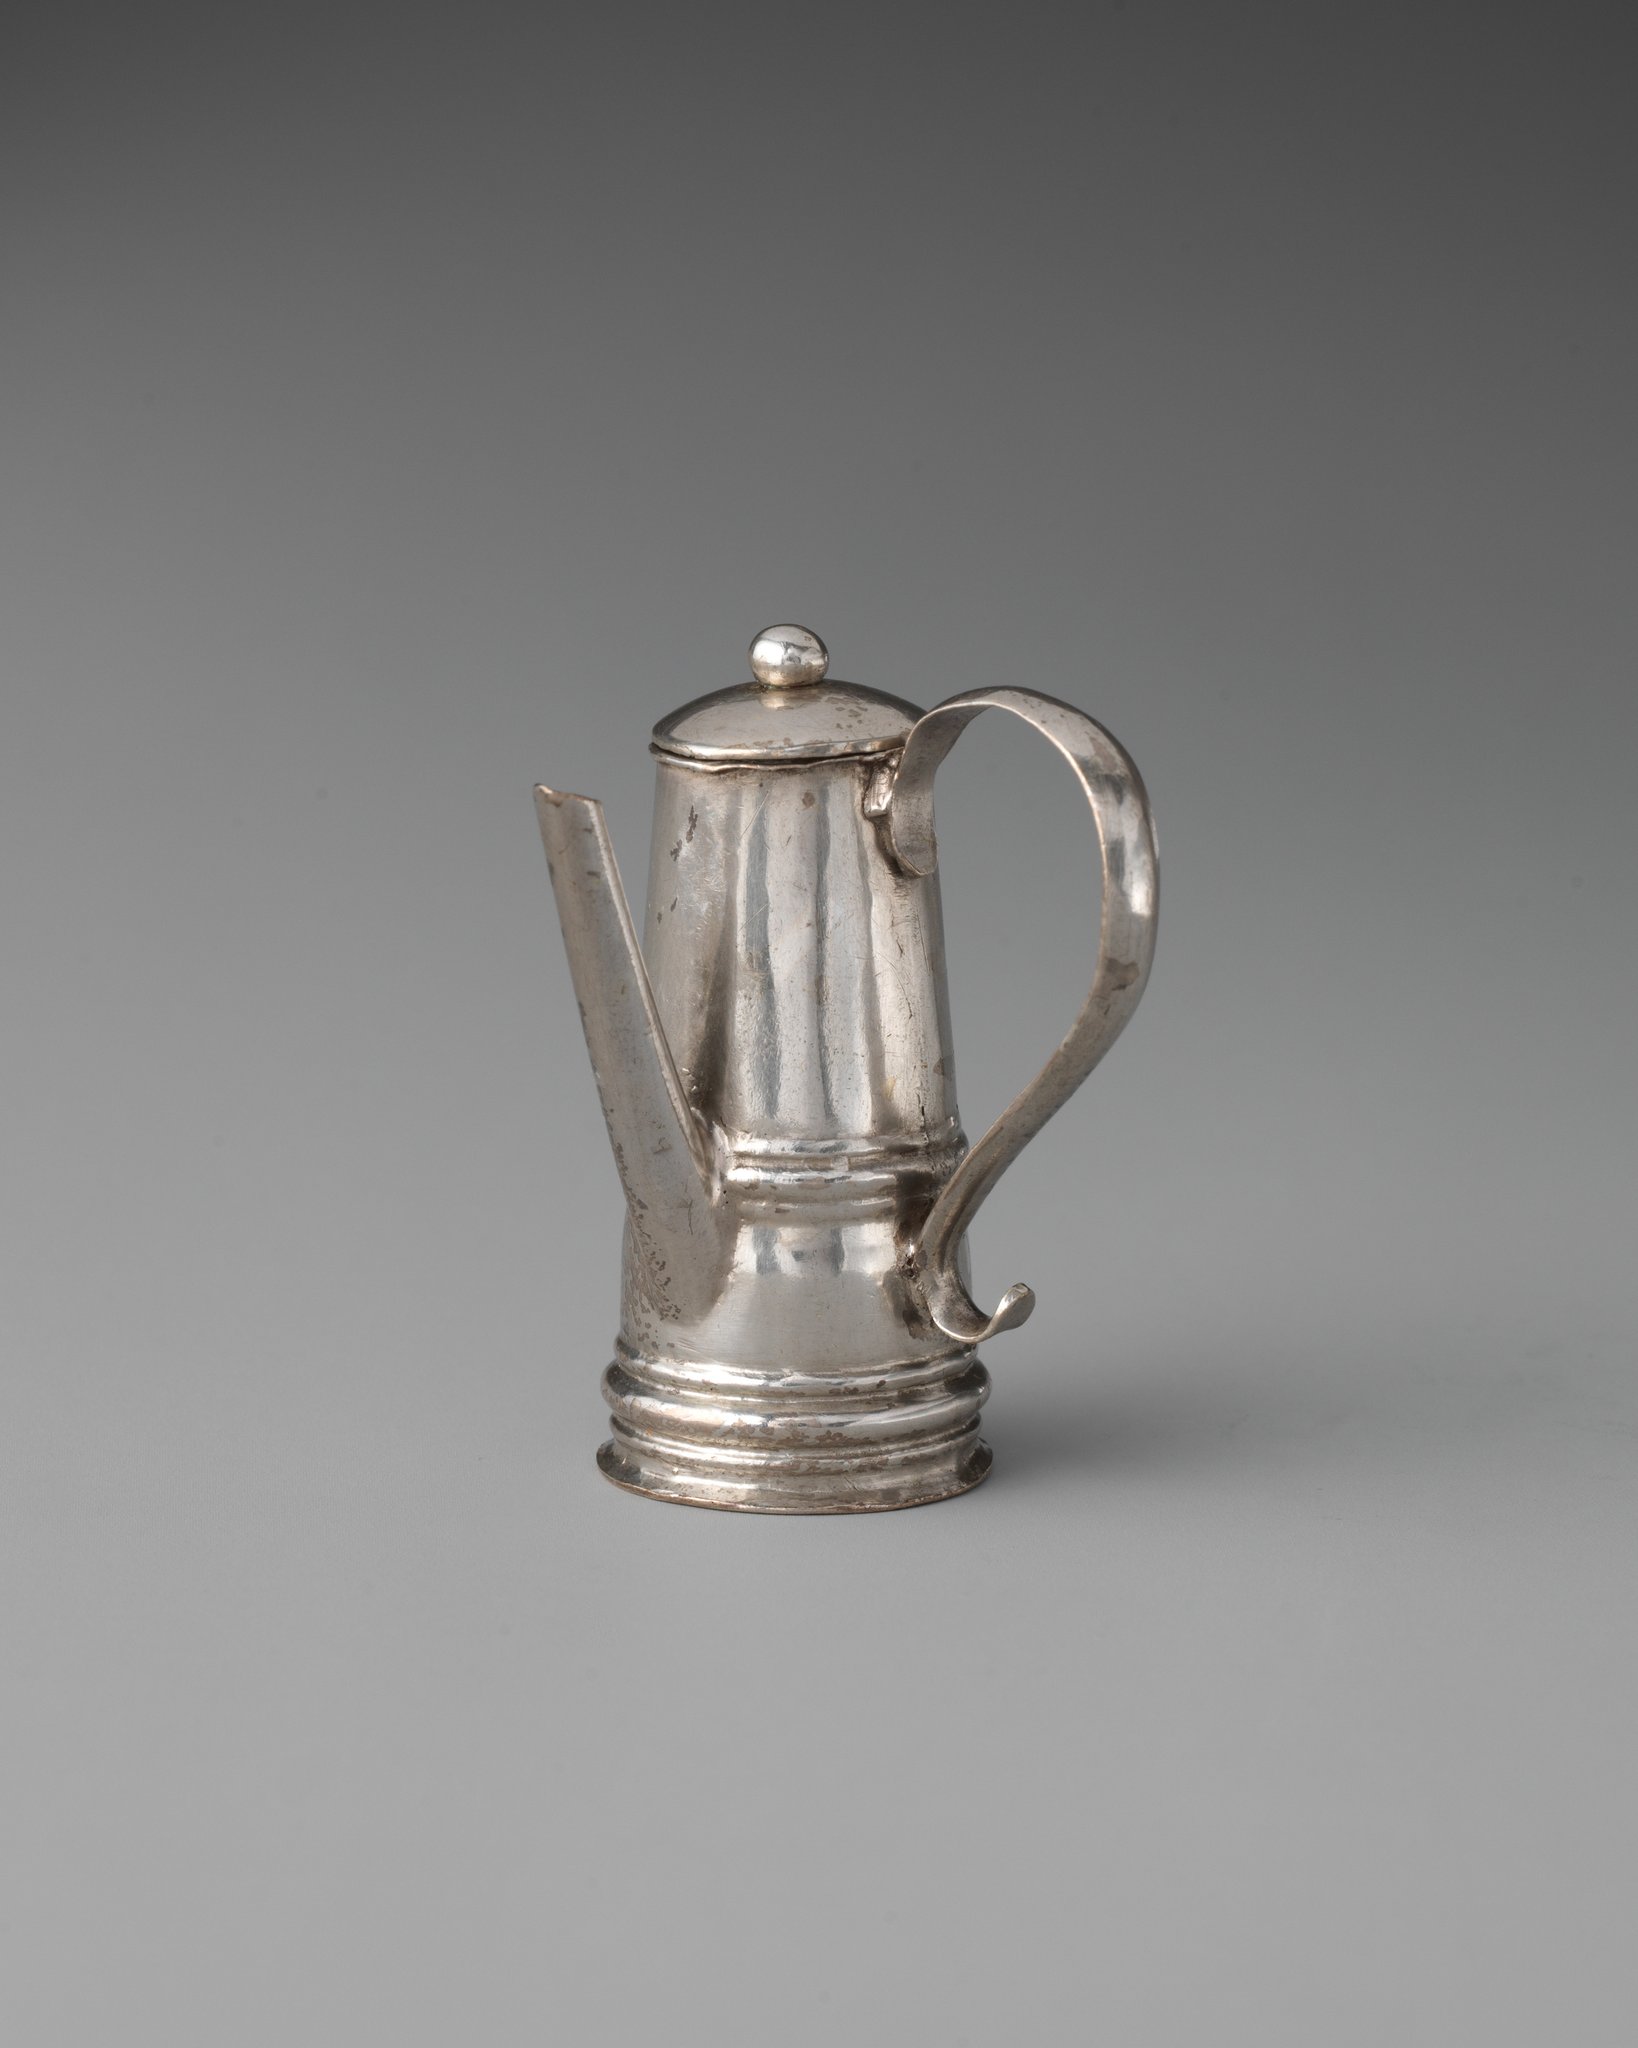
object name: coffeepot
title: Miniature coffeepot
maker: elizabeth roker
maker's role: maker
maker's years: 1776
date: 1776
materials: silver